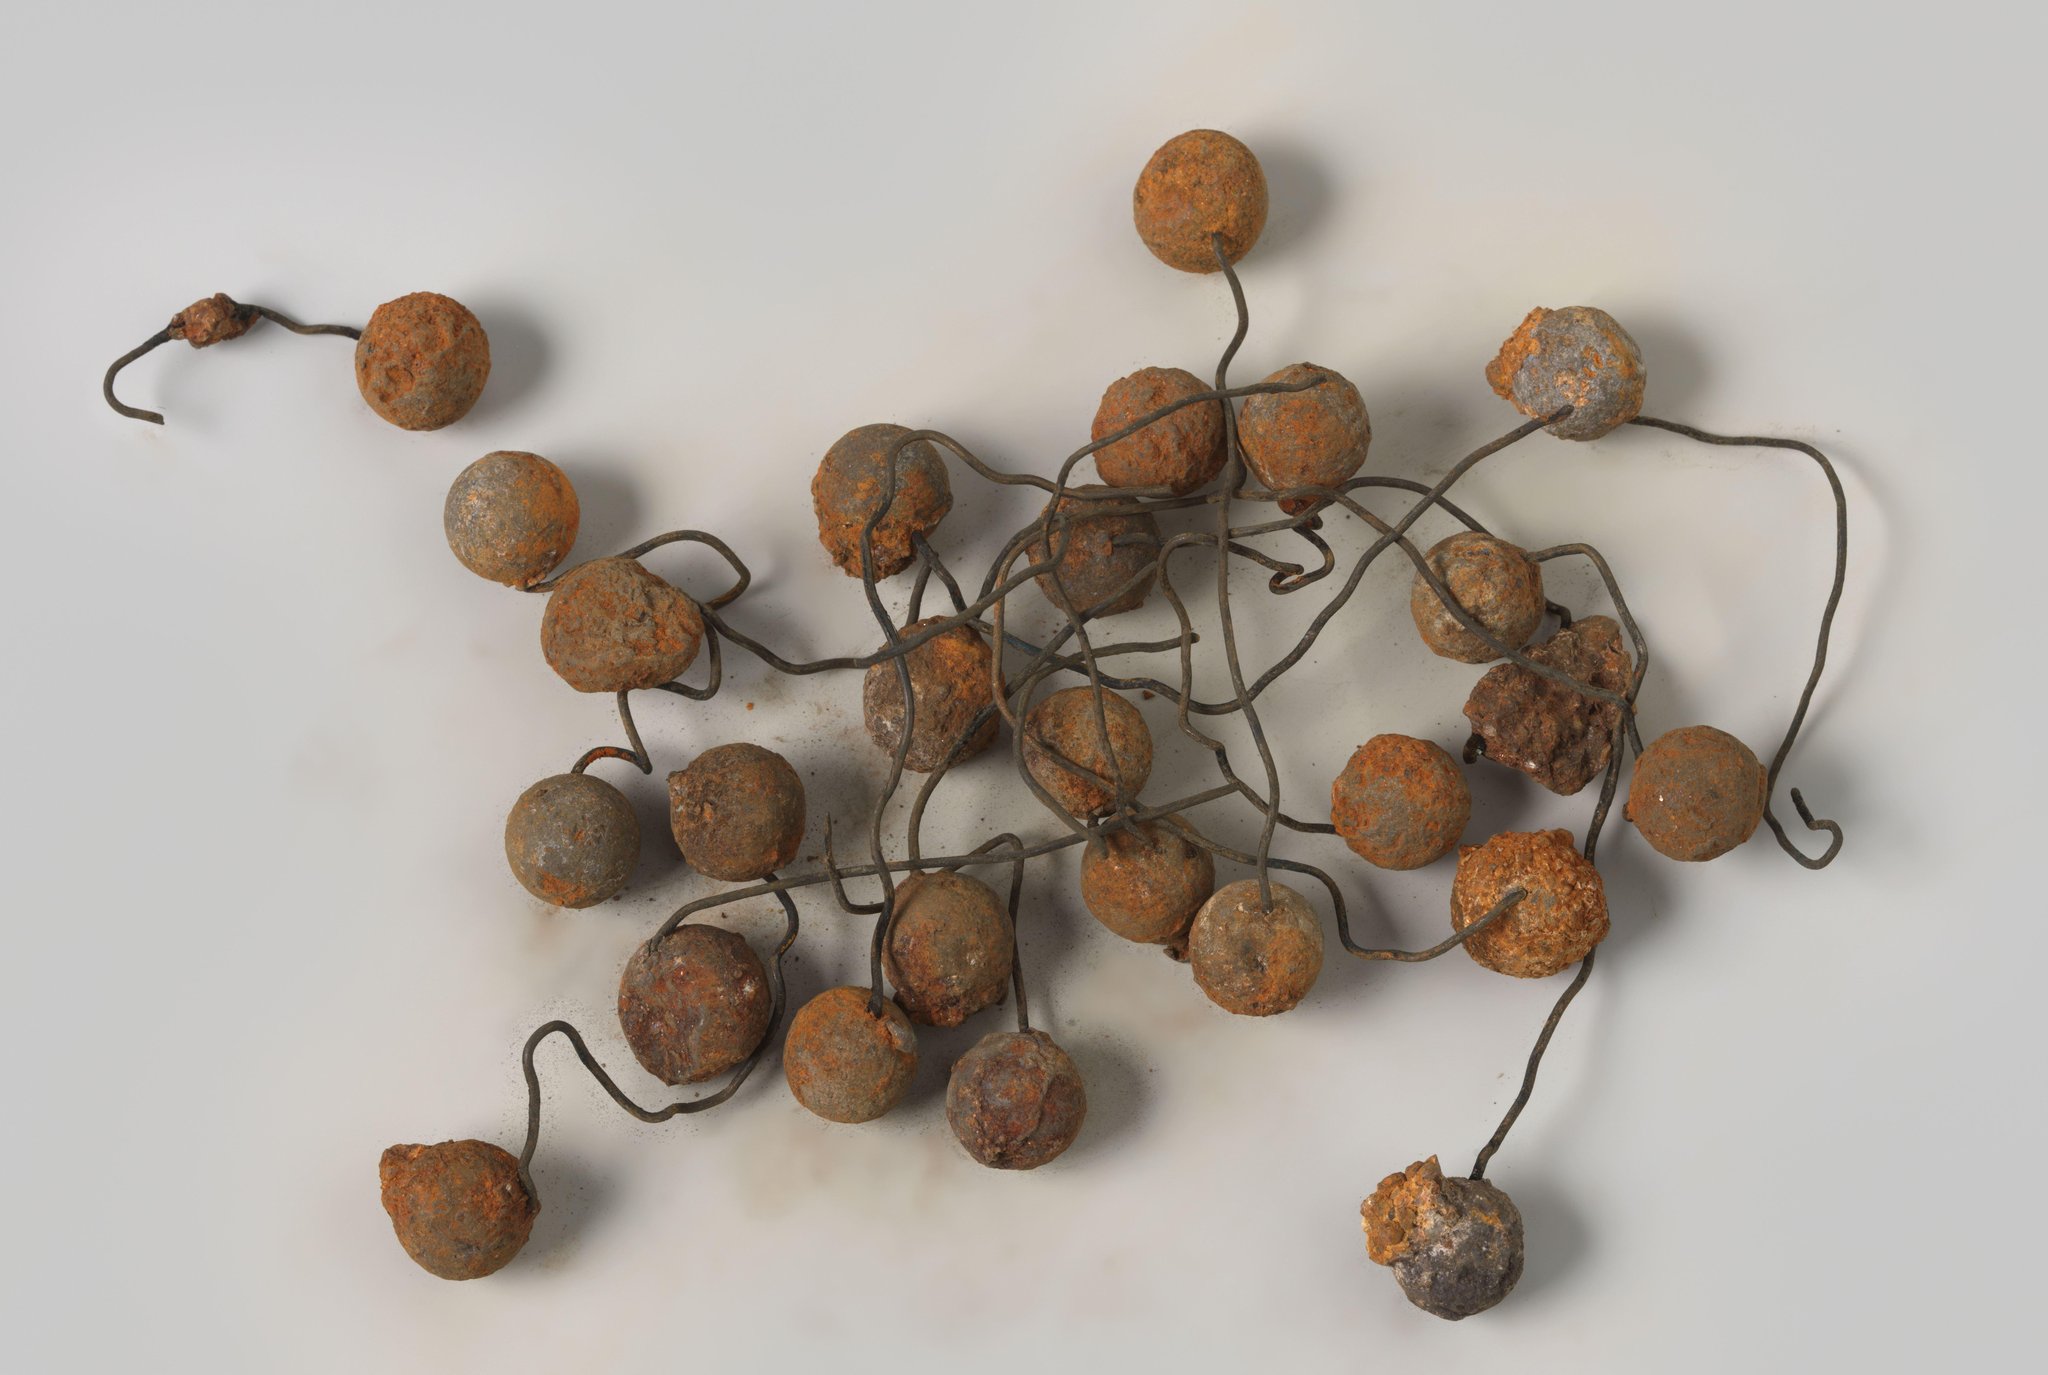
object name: chain shot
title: Kettingkogels uit het wrak van de Oost-Indiëvaarder Hollandia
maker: Anonymous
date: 1700-1743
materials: lead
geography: netherlands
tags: verenigde oostindische compagnie, hollandia (schip), annet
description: Shot, springshot; 2 balls with wire: fragment single balls with wire fragment, id. NG 1980-27H3168.